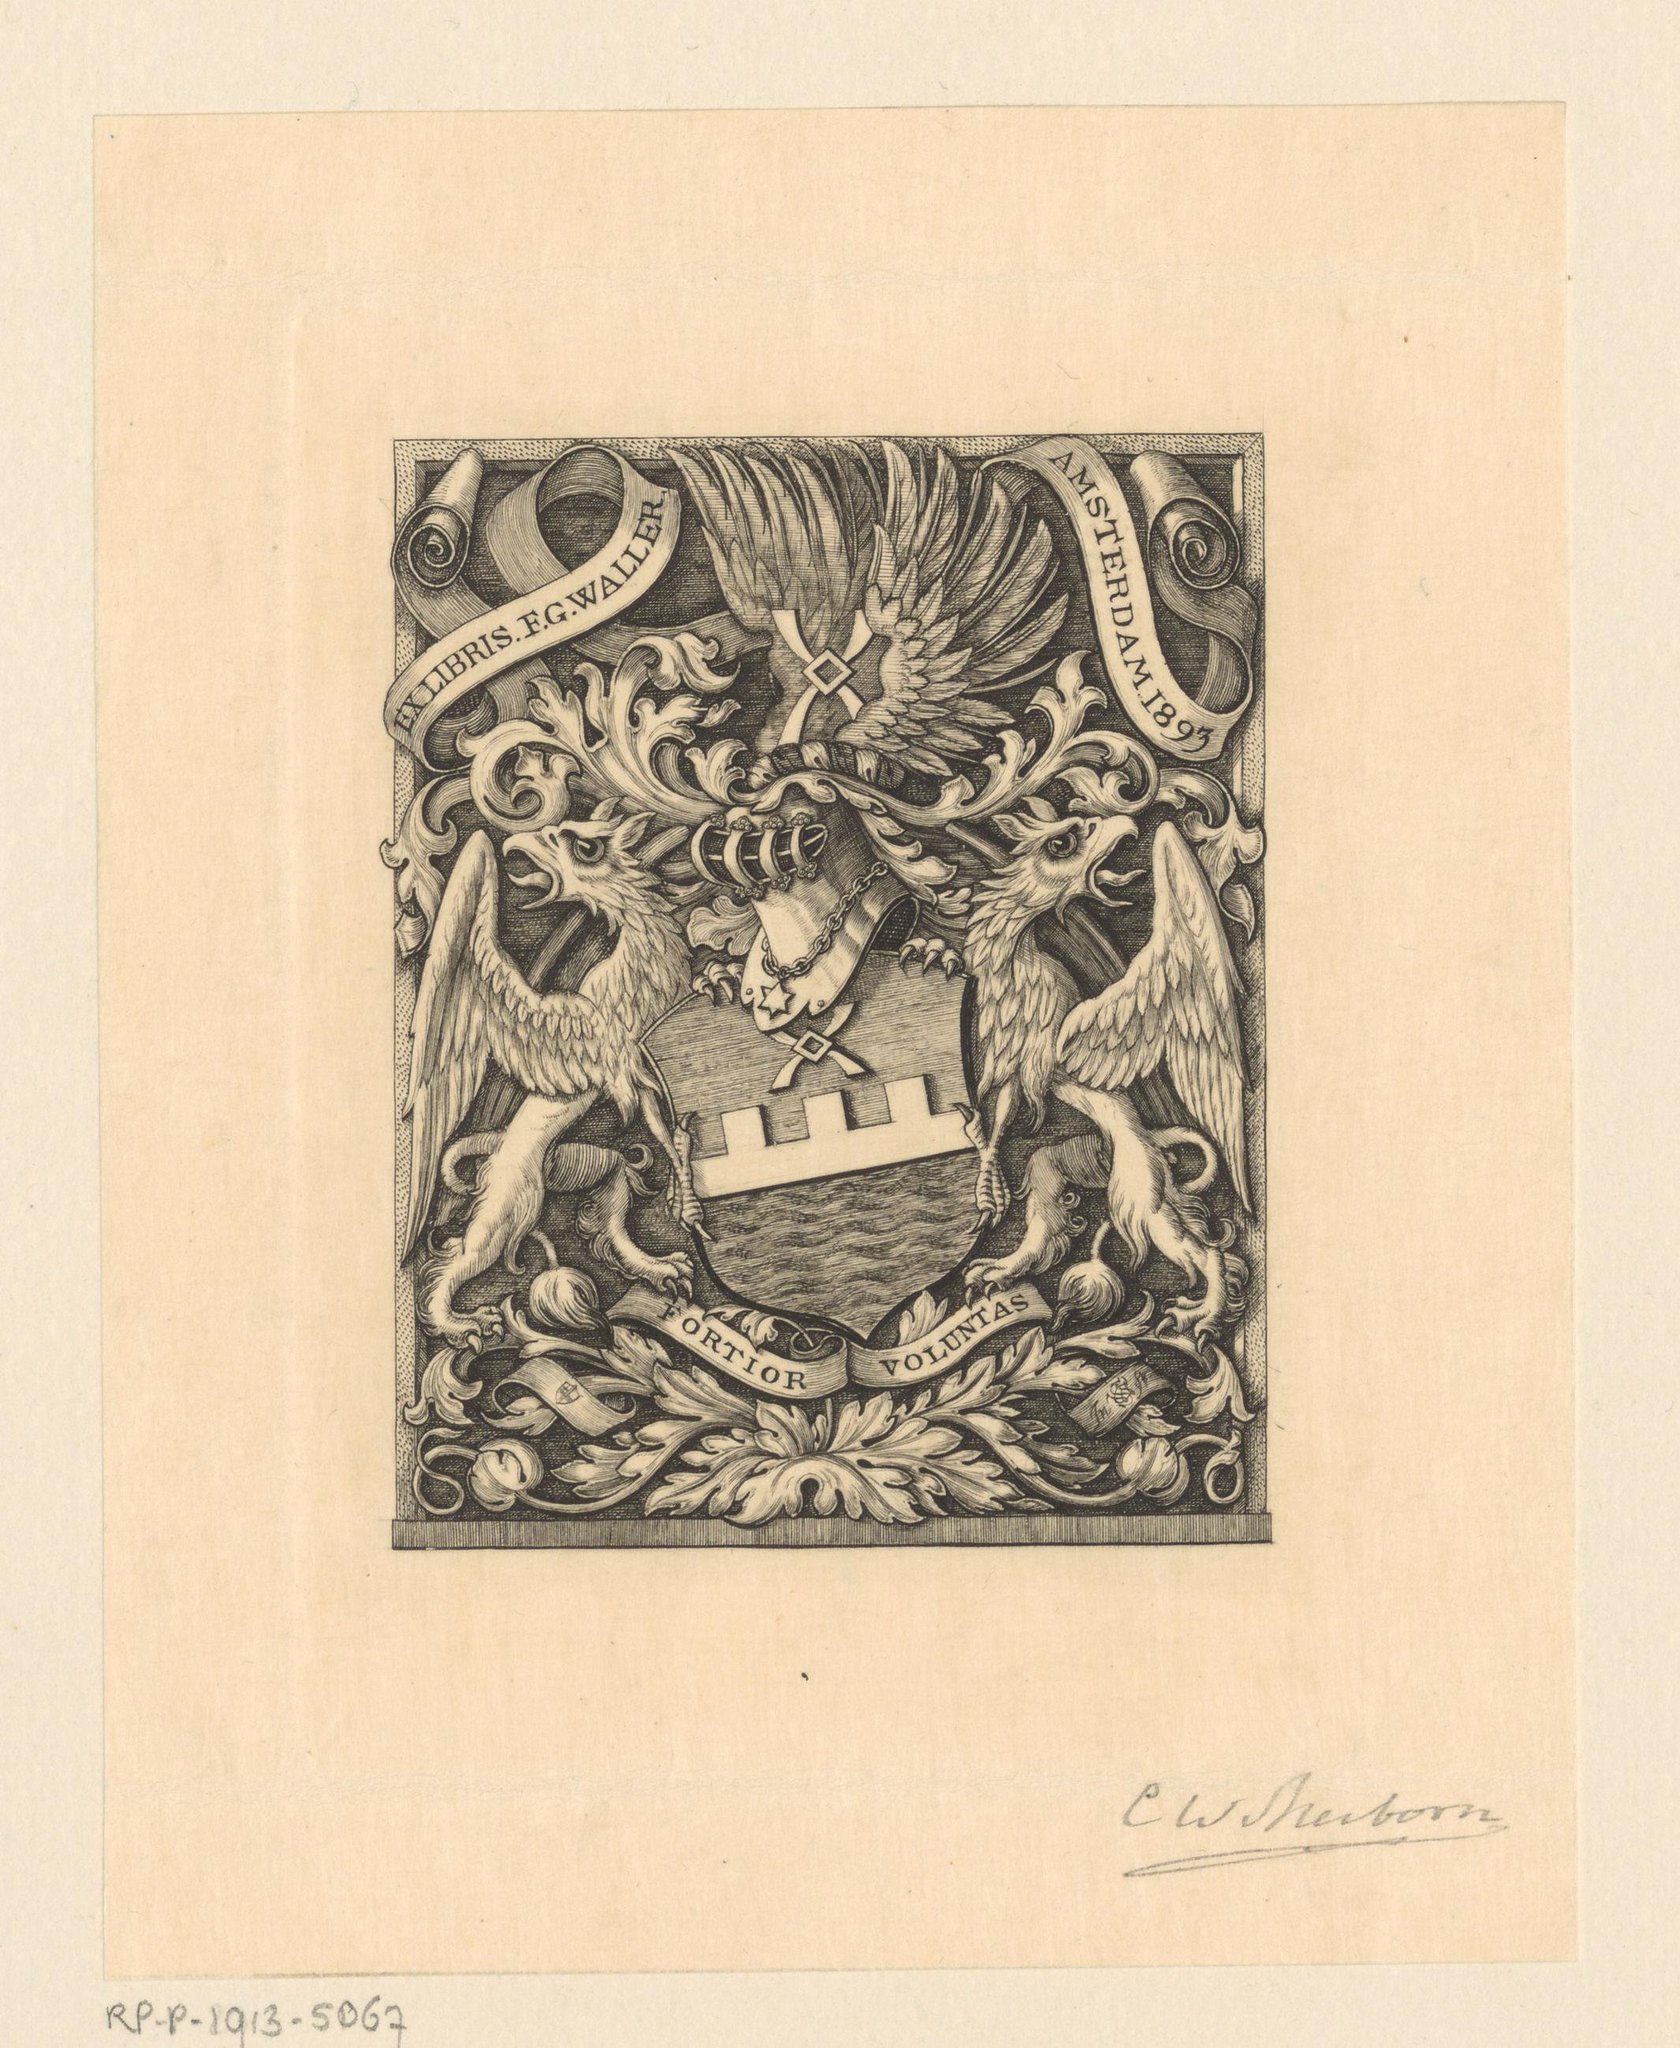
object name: bookplate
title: Ex libris van F.G. Waller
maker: charles william sherborn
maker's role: print maker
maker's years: 1831-1912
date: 1893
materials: paper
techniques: engraving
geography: netherlands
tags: griffin (lion/eagle); 'griffo' (ripa), foliage ~ ornament - aa - stylized, armorial bearing, heraldry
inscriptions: signature: ‘C W Sherborn’